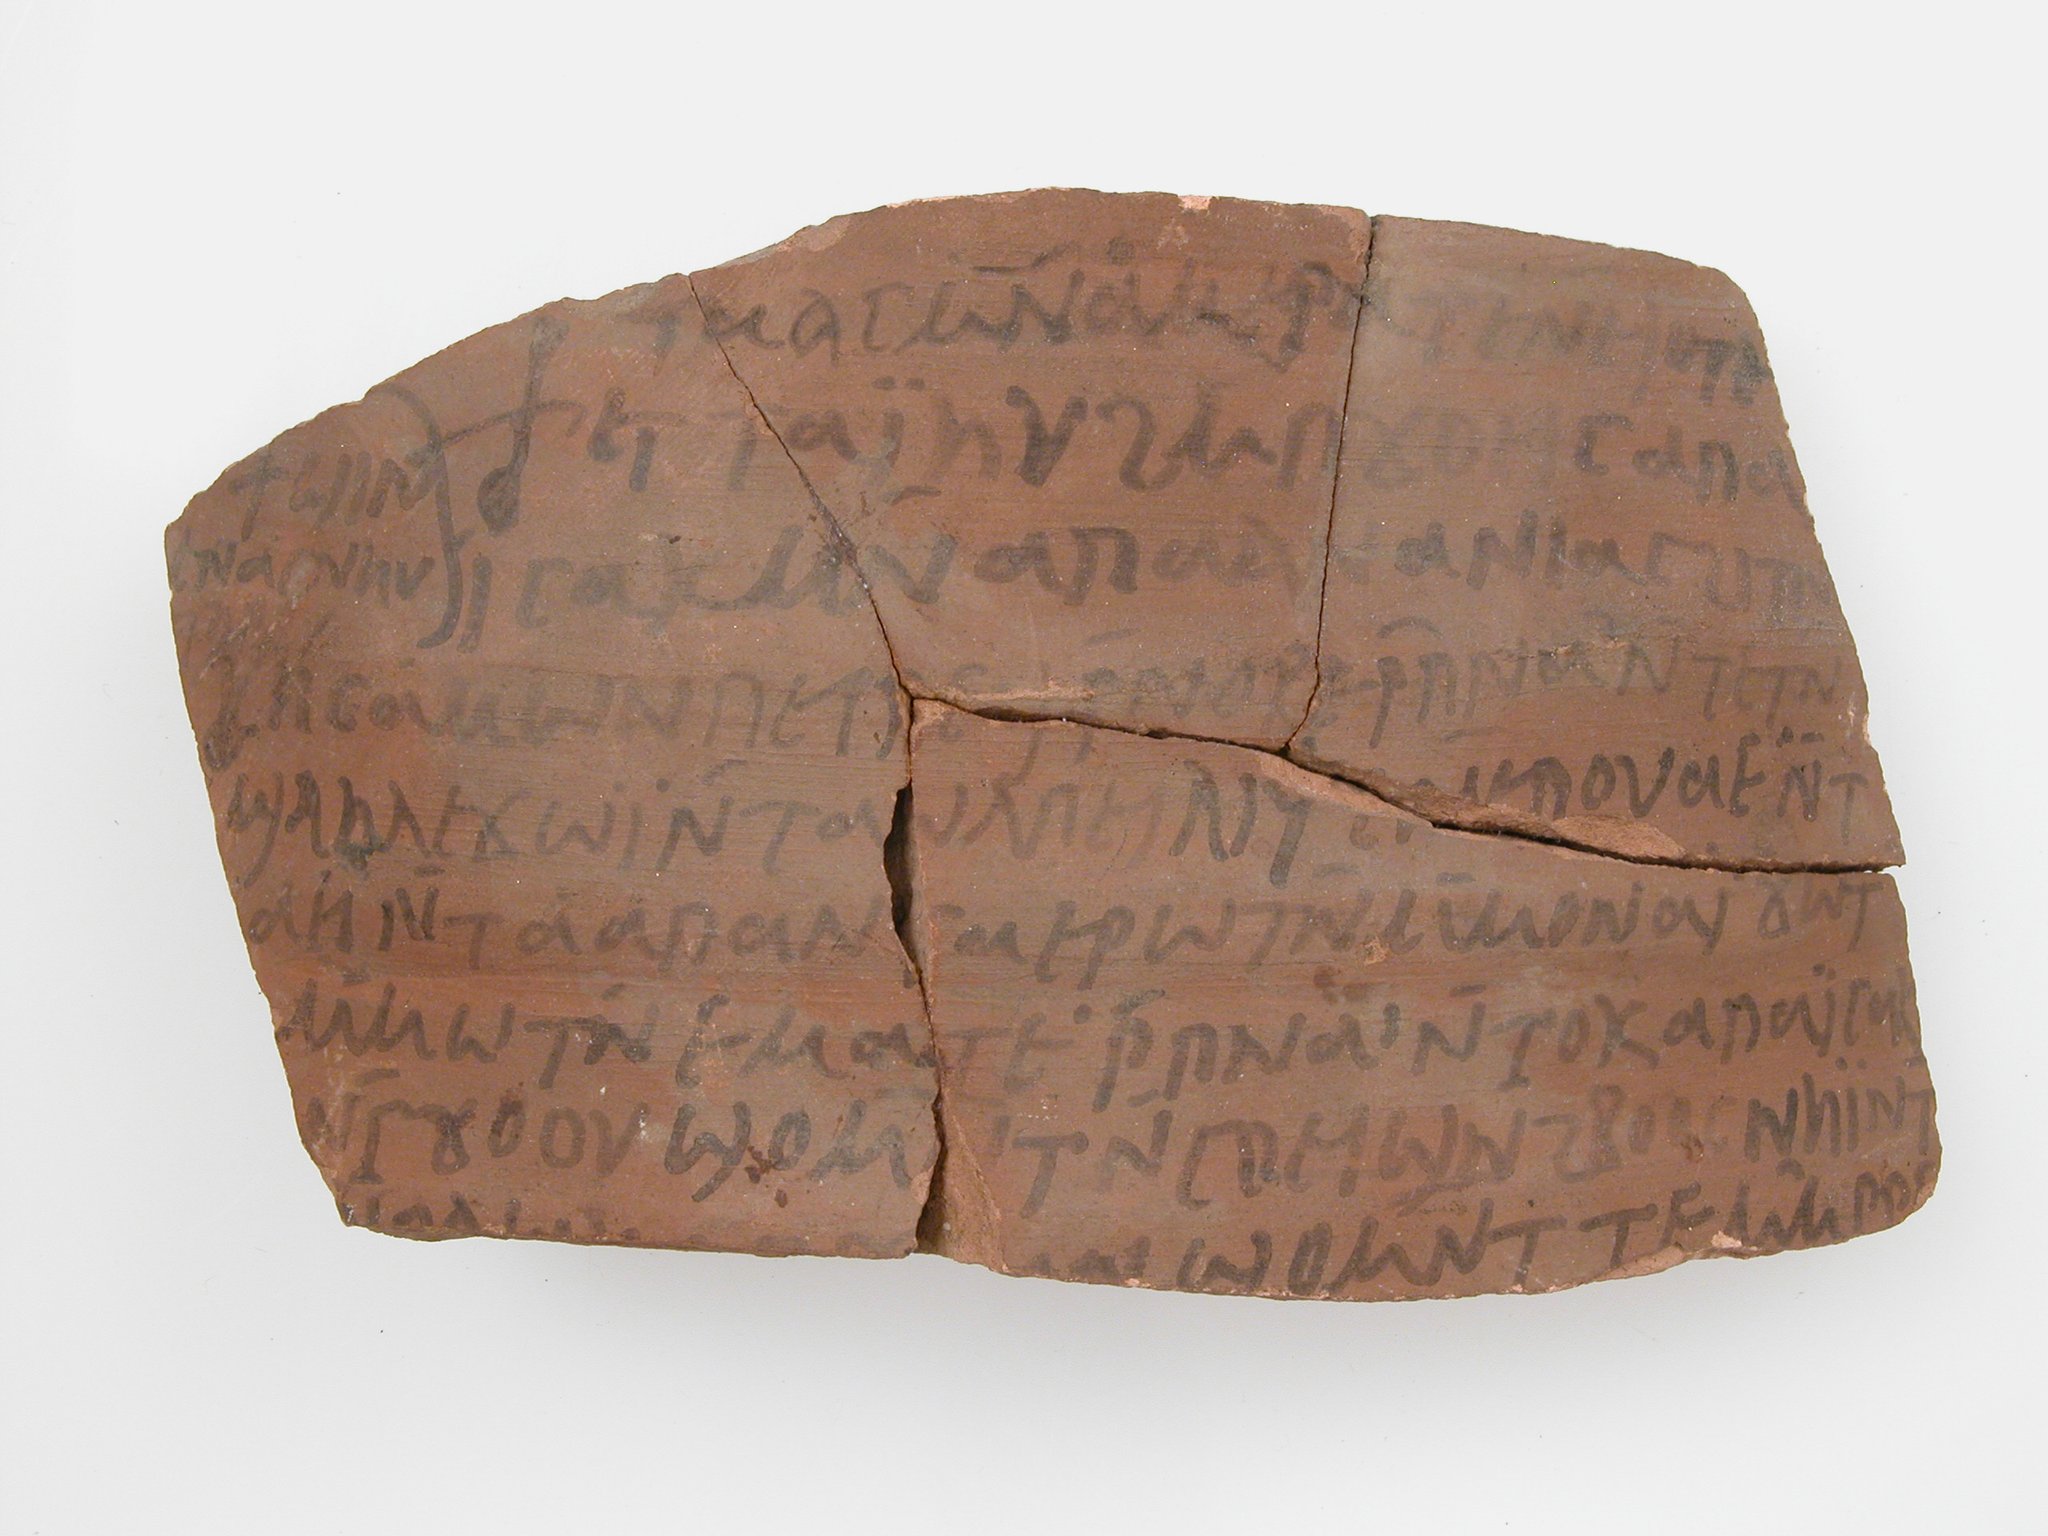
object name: ostrakon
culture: coptic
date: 601-700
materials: ink, pottery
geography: egypt